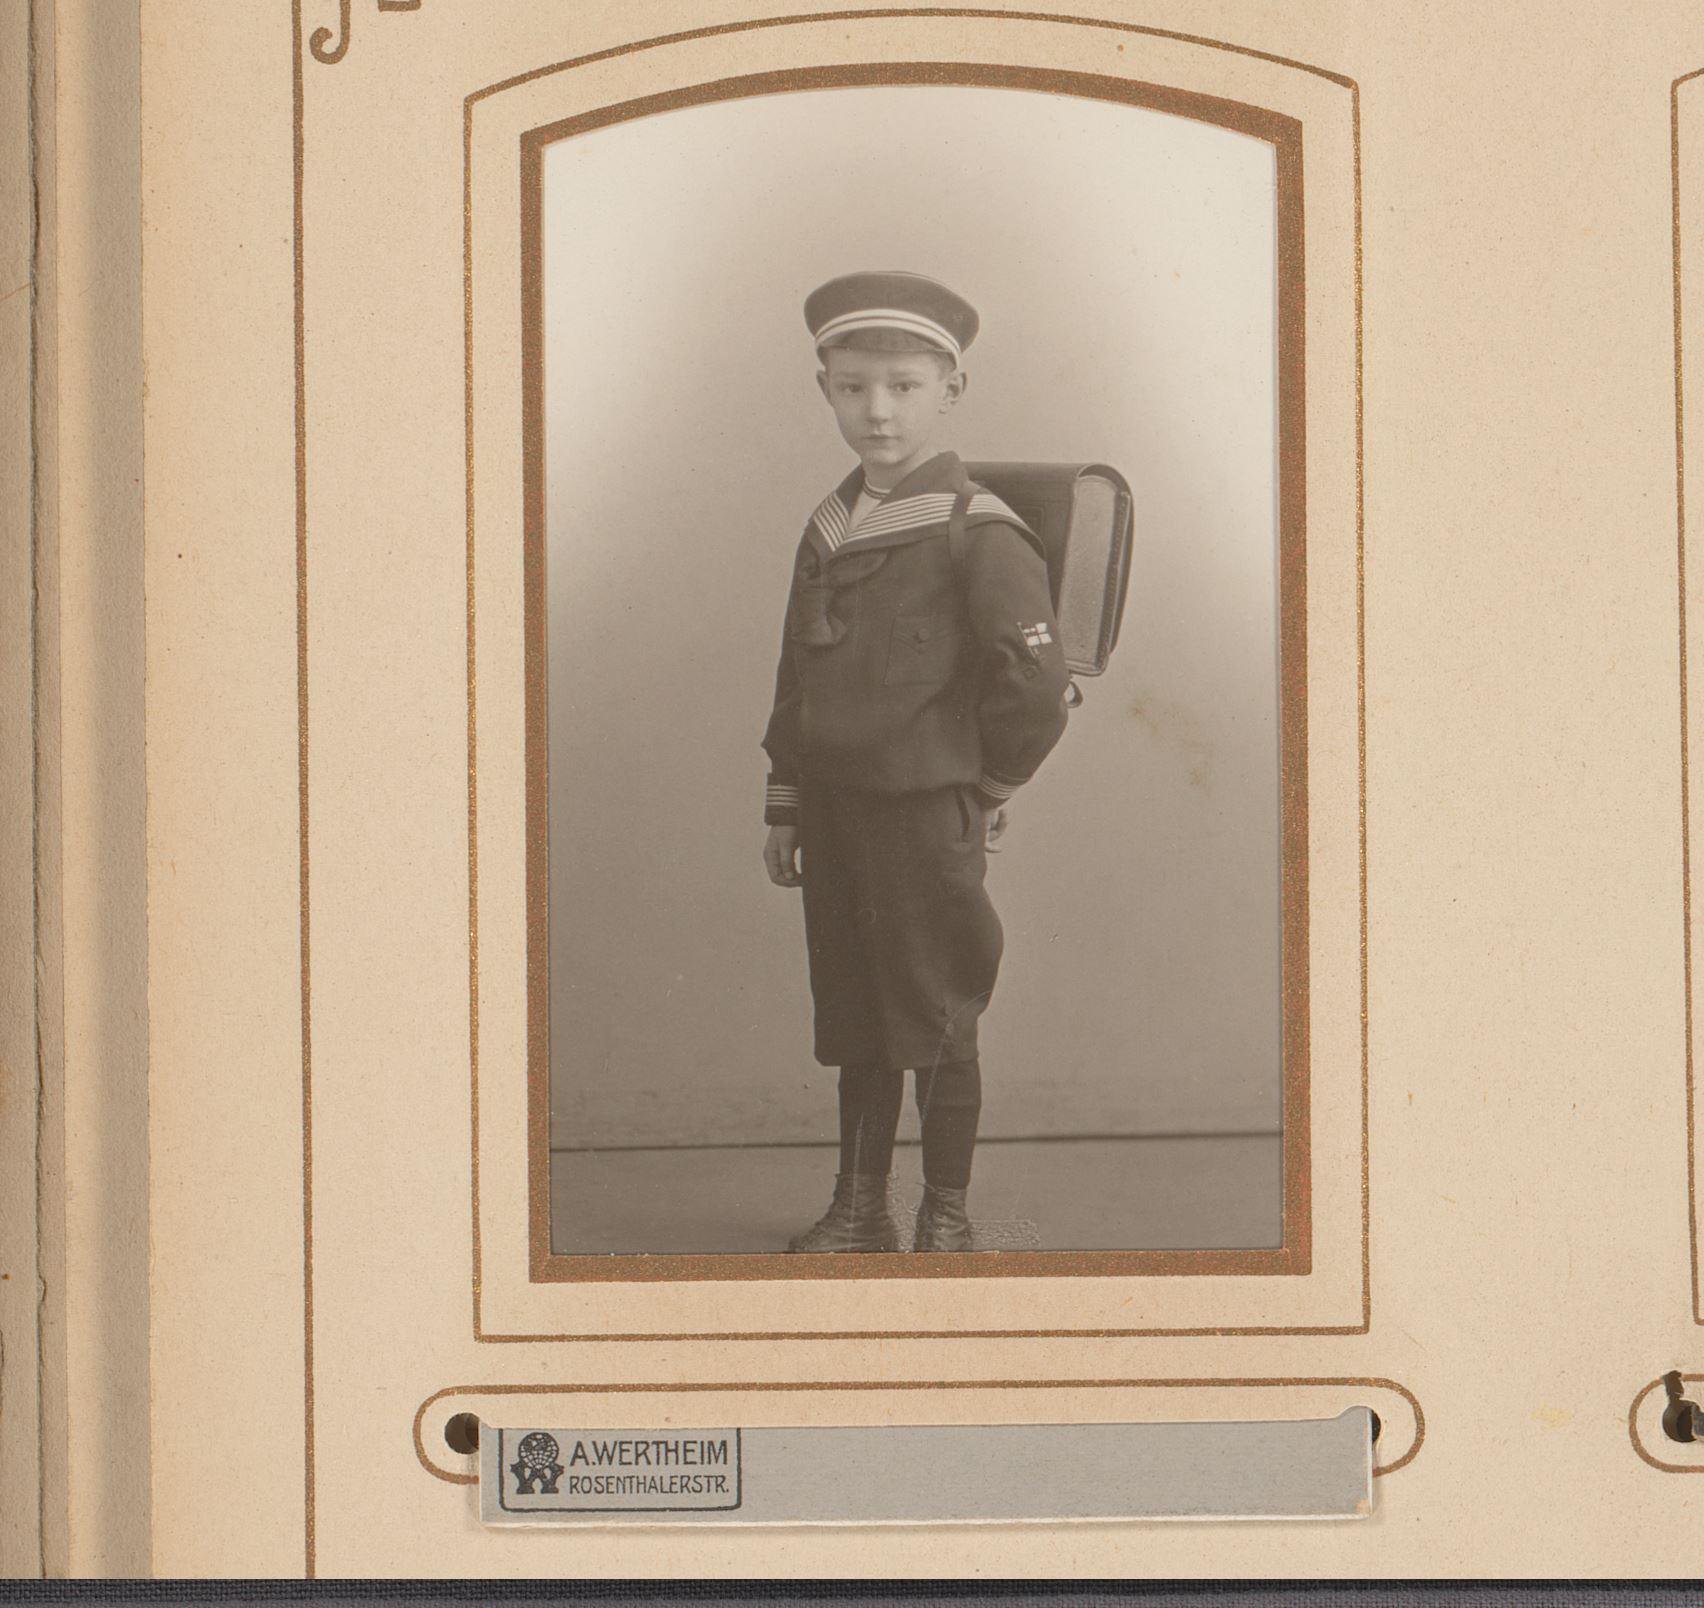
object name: album leaf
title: Portret van een jongen in een matrozenpak met rugzak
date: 1880-1910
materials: cardboard, photographic support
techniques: collodion silver print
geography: germany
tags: ensemble of pieces of clothing: sailor suit, boy (child between toddler and youth)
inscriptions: inscription: ‘A. Wertheim/ Rosenthalerstr.’